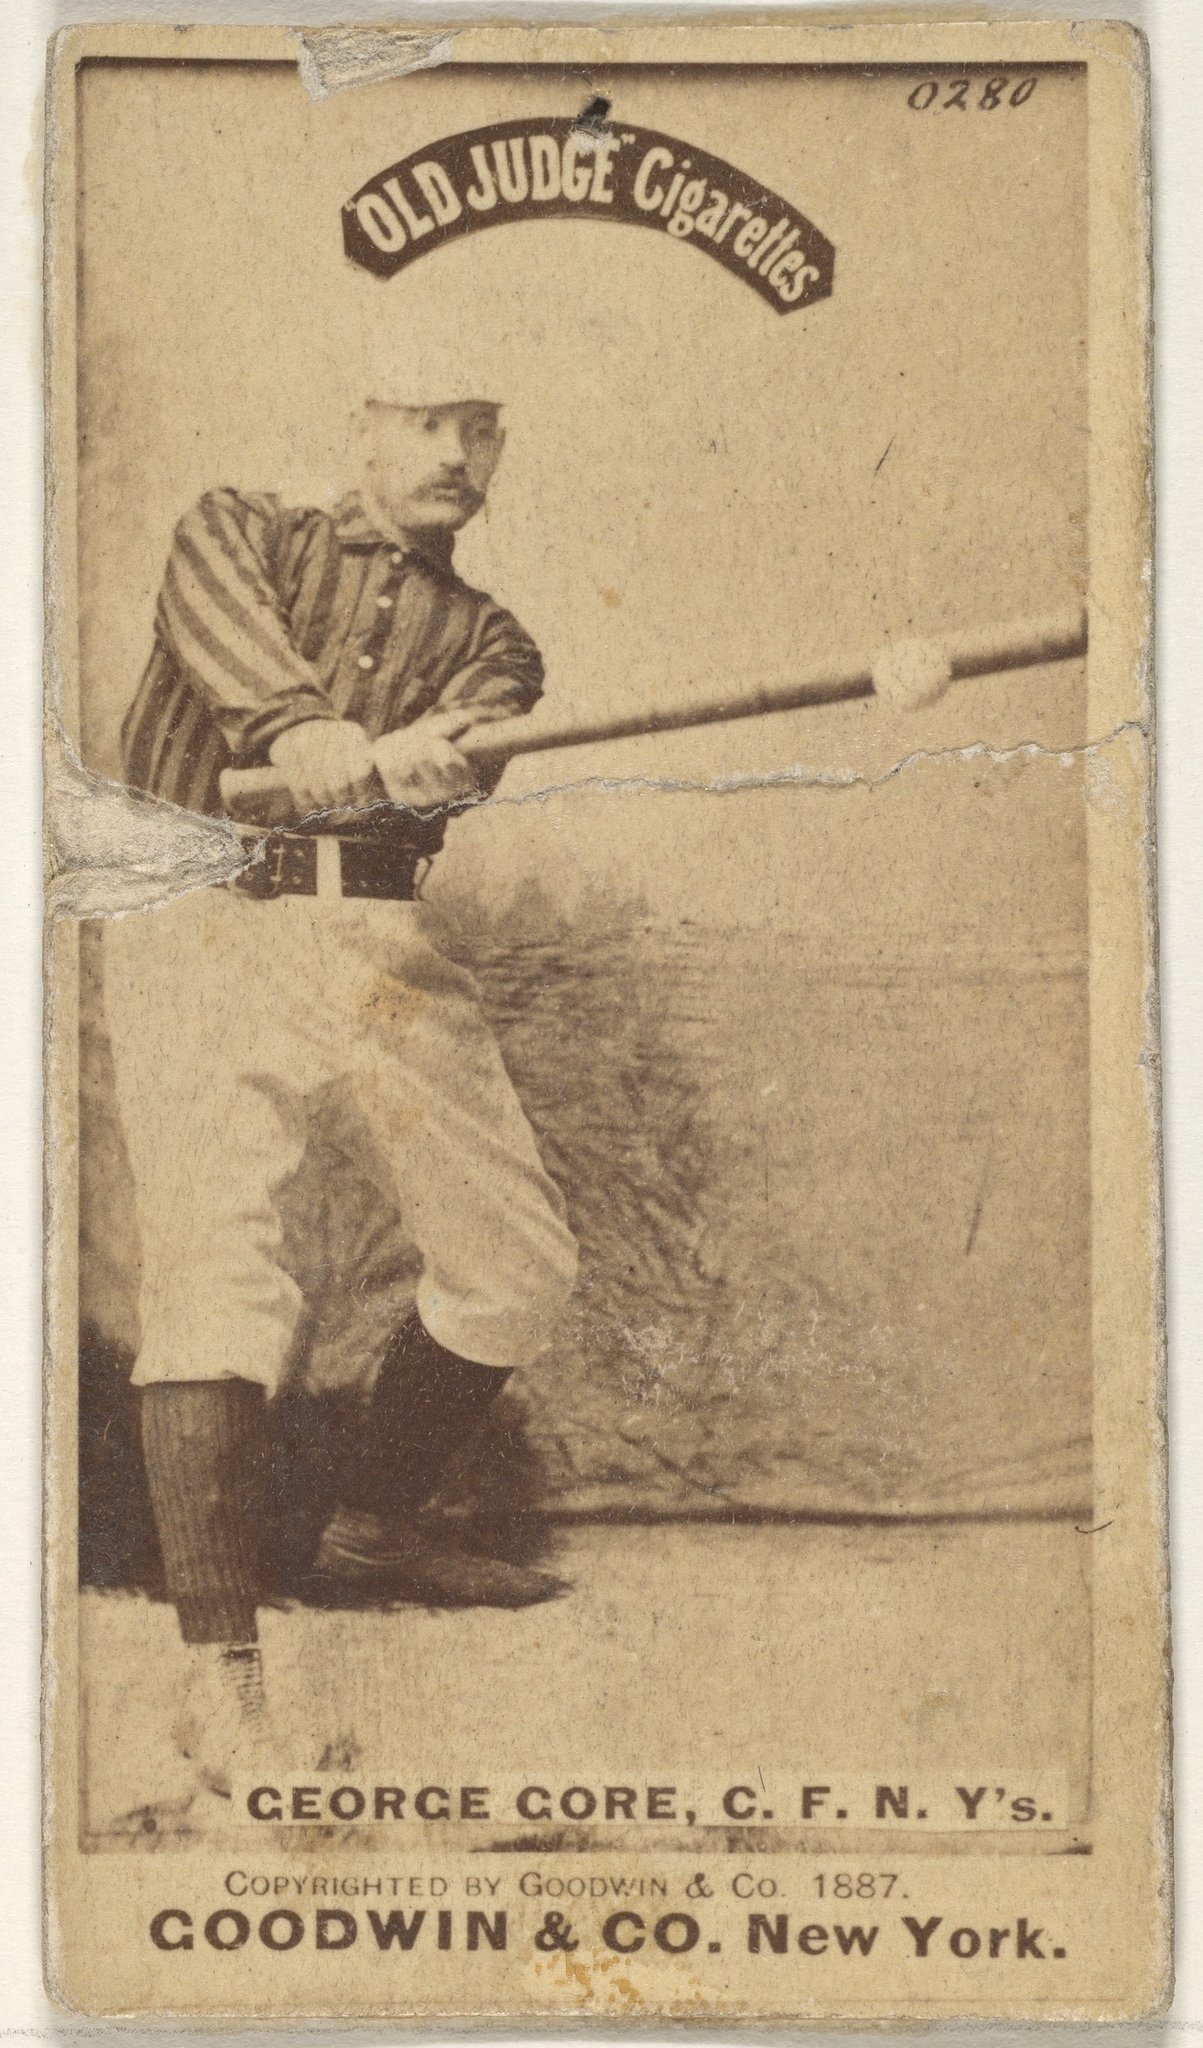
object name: baseball card, photograph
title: George F. "Piano Legs" Gore, Center Field, New York, from the Old Judge series (N172) for Old Judge Cigarettes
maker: goodwin & company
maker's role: publisher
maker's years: 1850-1950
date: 1887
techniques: albumen silver print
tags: men,portraits,baseball,athletes